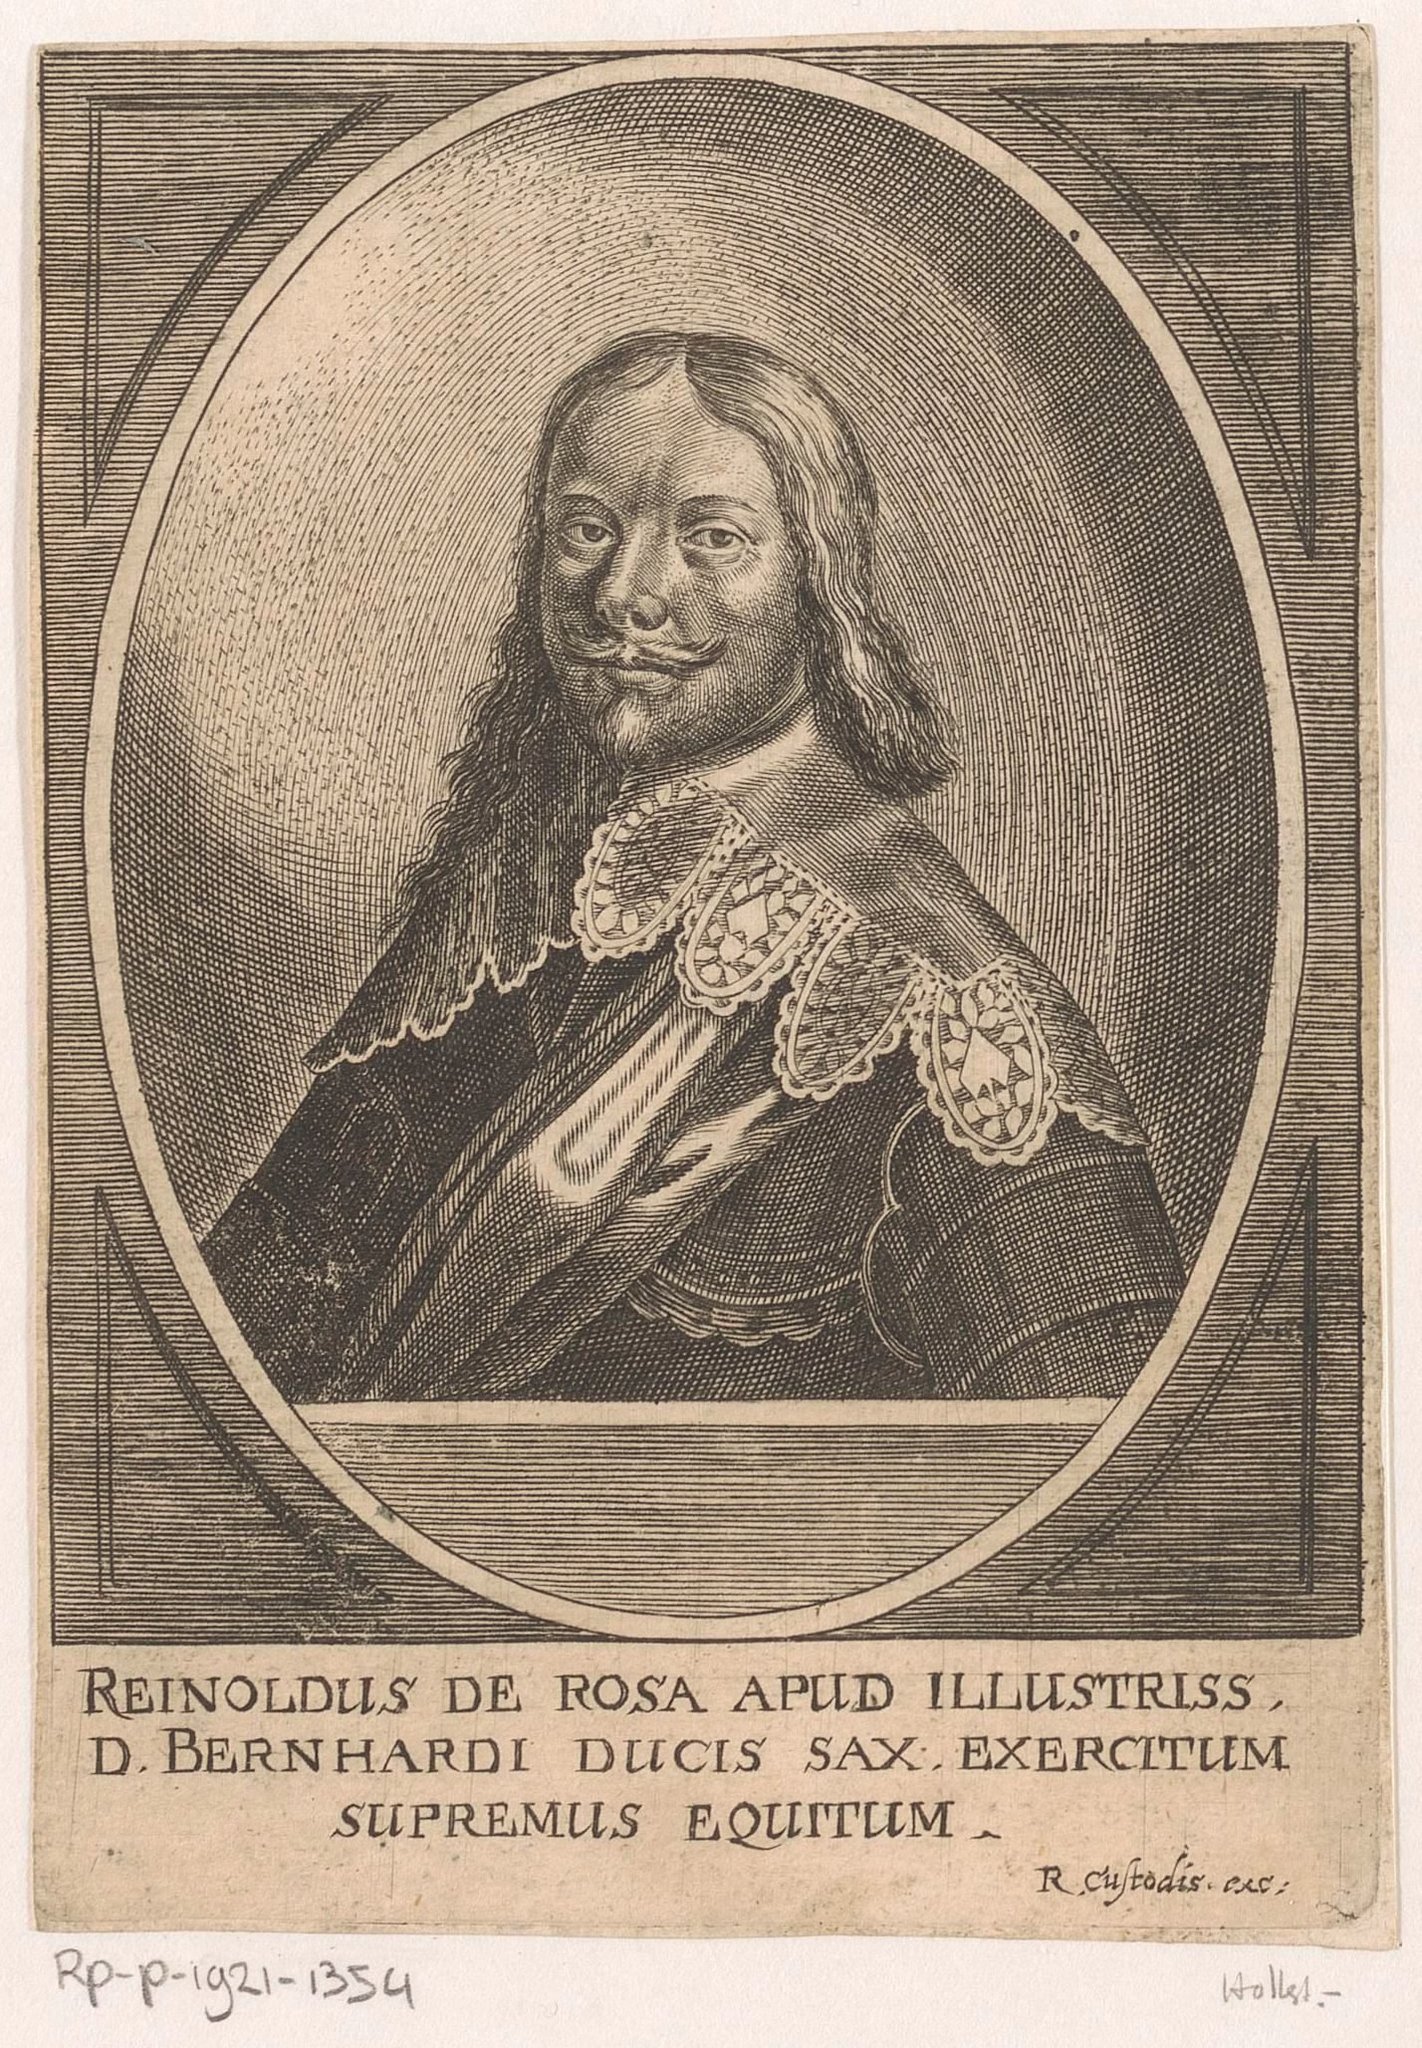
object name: print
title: Portret van Reinhold von Rosen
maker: raphael custos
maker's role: print maker, publisher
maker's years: 1590-1664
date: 1600-1664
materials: paper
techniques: engraving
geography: augsburg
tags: historical persons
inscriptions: collector's mark: Lugt 2233